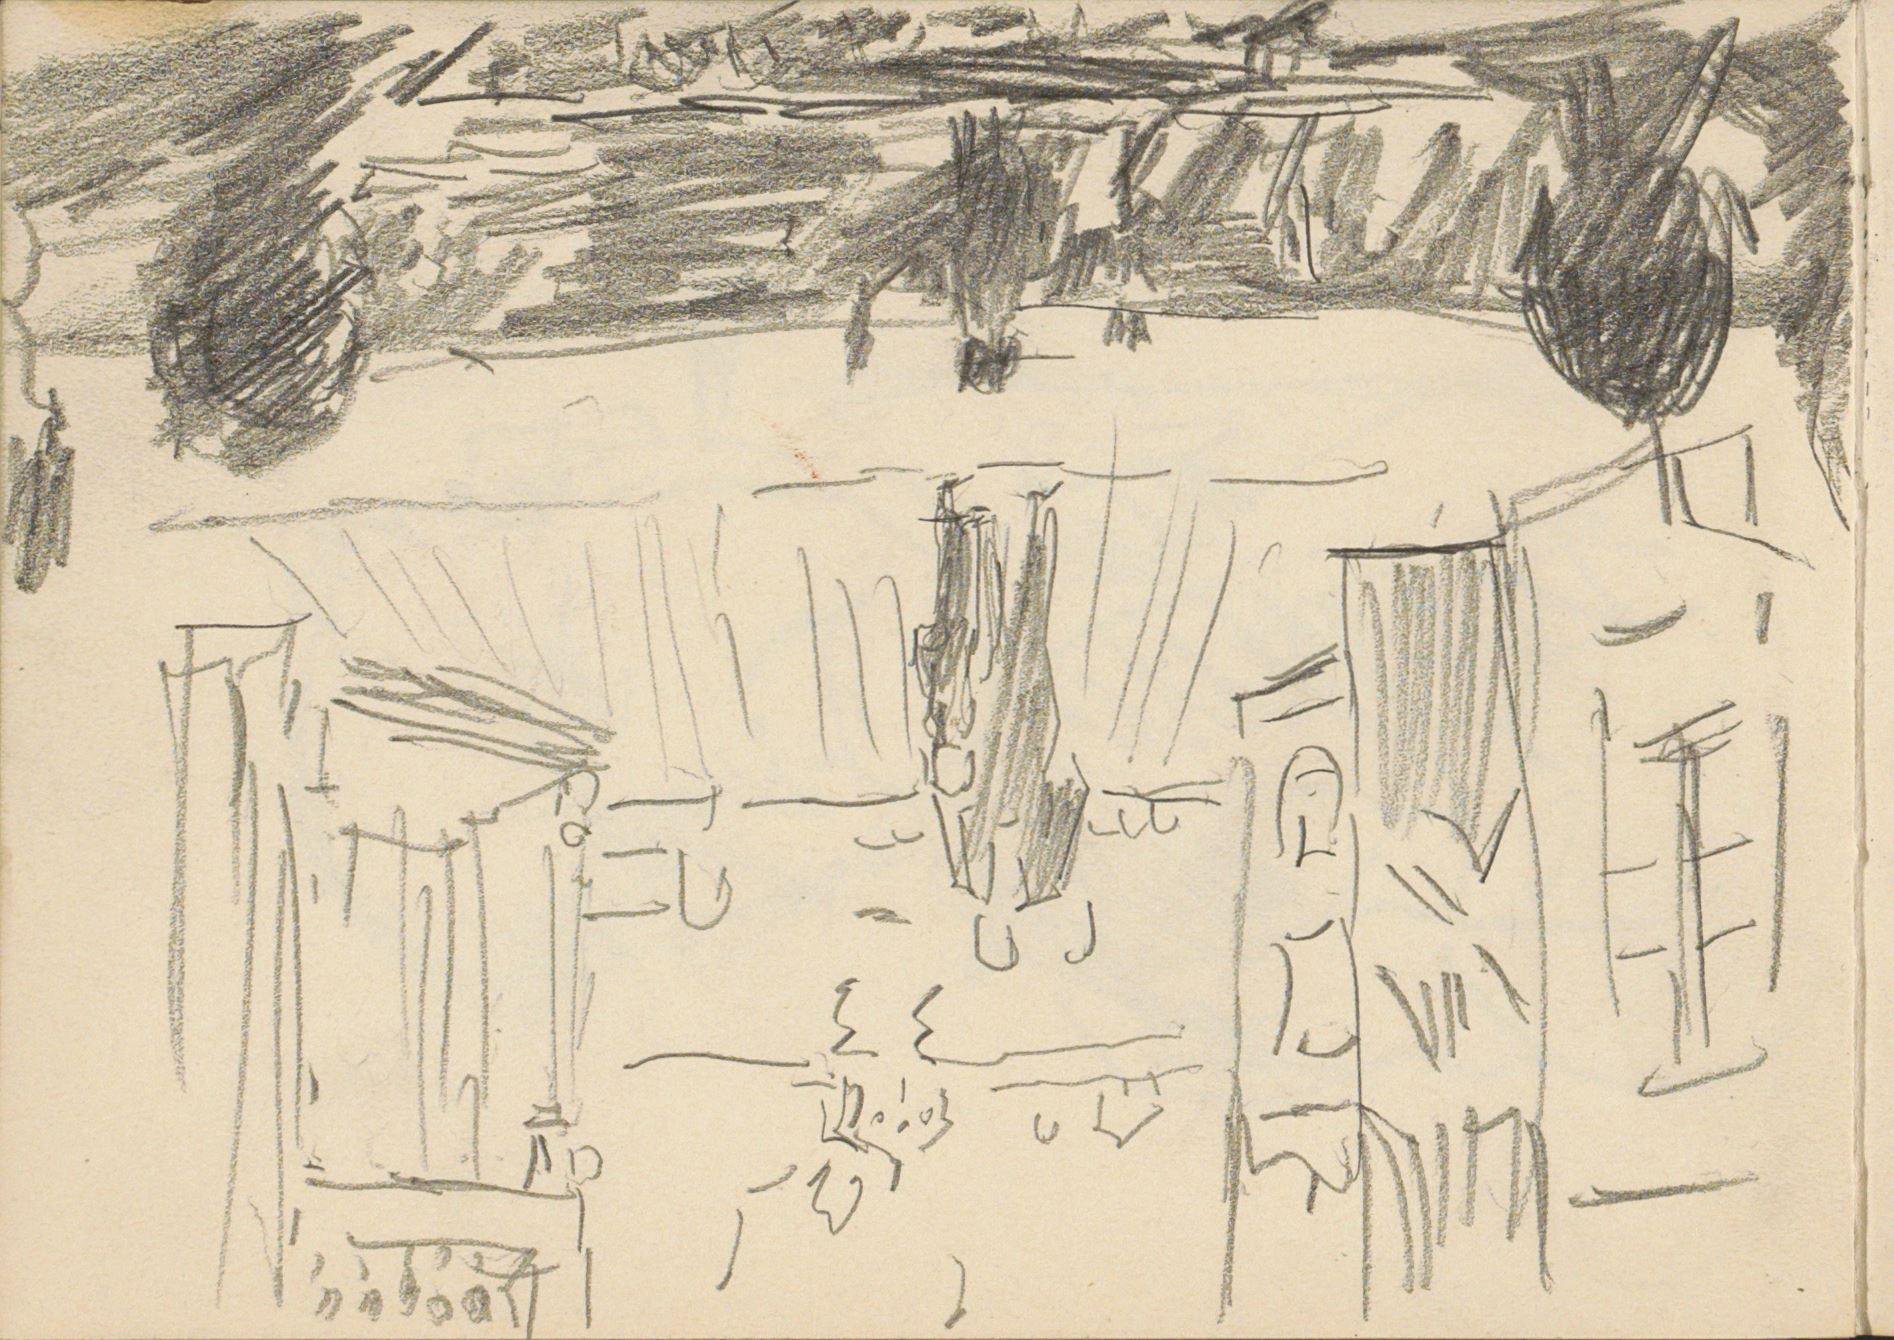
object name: sketchbook leaf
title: Theatervoorstelling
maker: isaac israels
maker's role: draughtsman, painter, print maker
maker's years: 1865-1934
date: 1930-1934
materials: paper, pencil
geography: the hague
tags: group of actors, troupe; actors on the stage, the audience ~ art performance, conductor ~ music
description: Twee acteurs op het toneel. Voor het toneel de dirigent in de orkestbak. Op de voorgrond toeschouwers. Mogelijk in Theater Scala te Den Haag. Pagina 13 uit schetsboek XXXVIII met 45 pagina's.